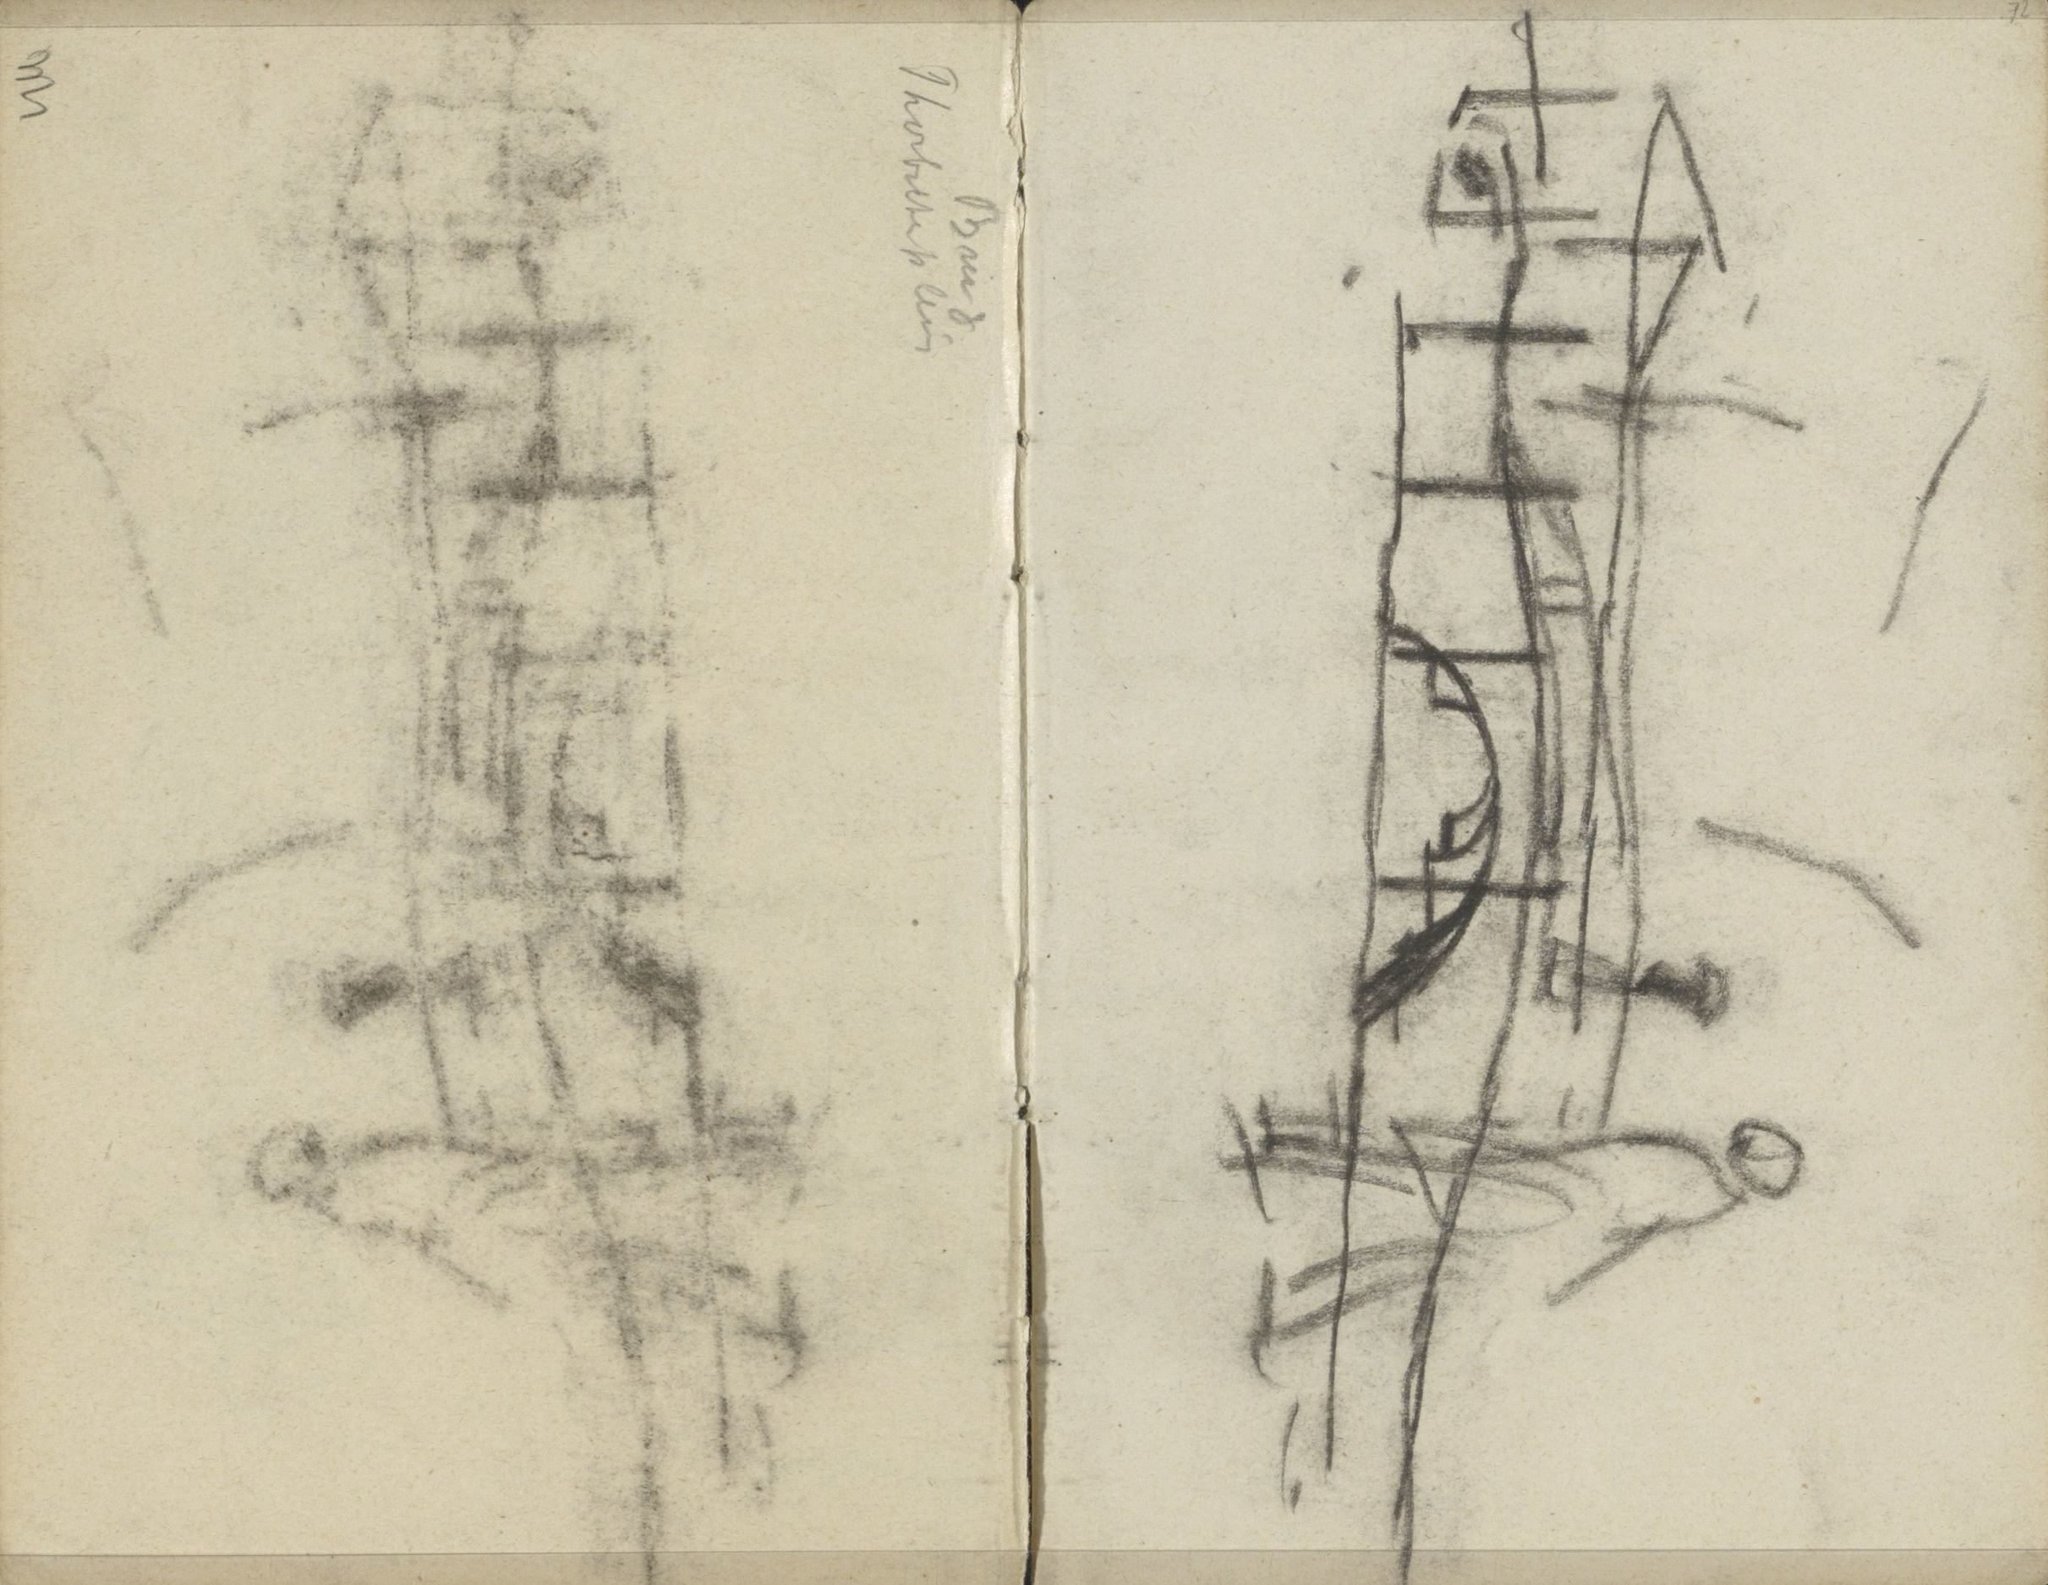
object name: sketchbook leaf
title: Brug over de Reguliersgracht te Amsterdam, gezien vanaf de brug over de Herengracht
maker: george hendrik breitner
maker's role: draughtsman, painter, print maker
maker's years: 1857-1923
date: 1910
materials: chalk, paper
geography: amsterdam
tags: bridge in city across river, canal, etc. (+ city(-scape) with figures, staffage)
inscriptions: annotation: ‘Brug./ Thorbeckeplein’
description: Ter hoogte van het Thorbeckeplein. Vooraan een figuur. Pagina 71 en pagina 72 uit een schetsboek met 45 bladen.